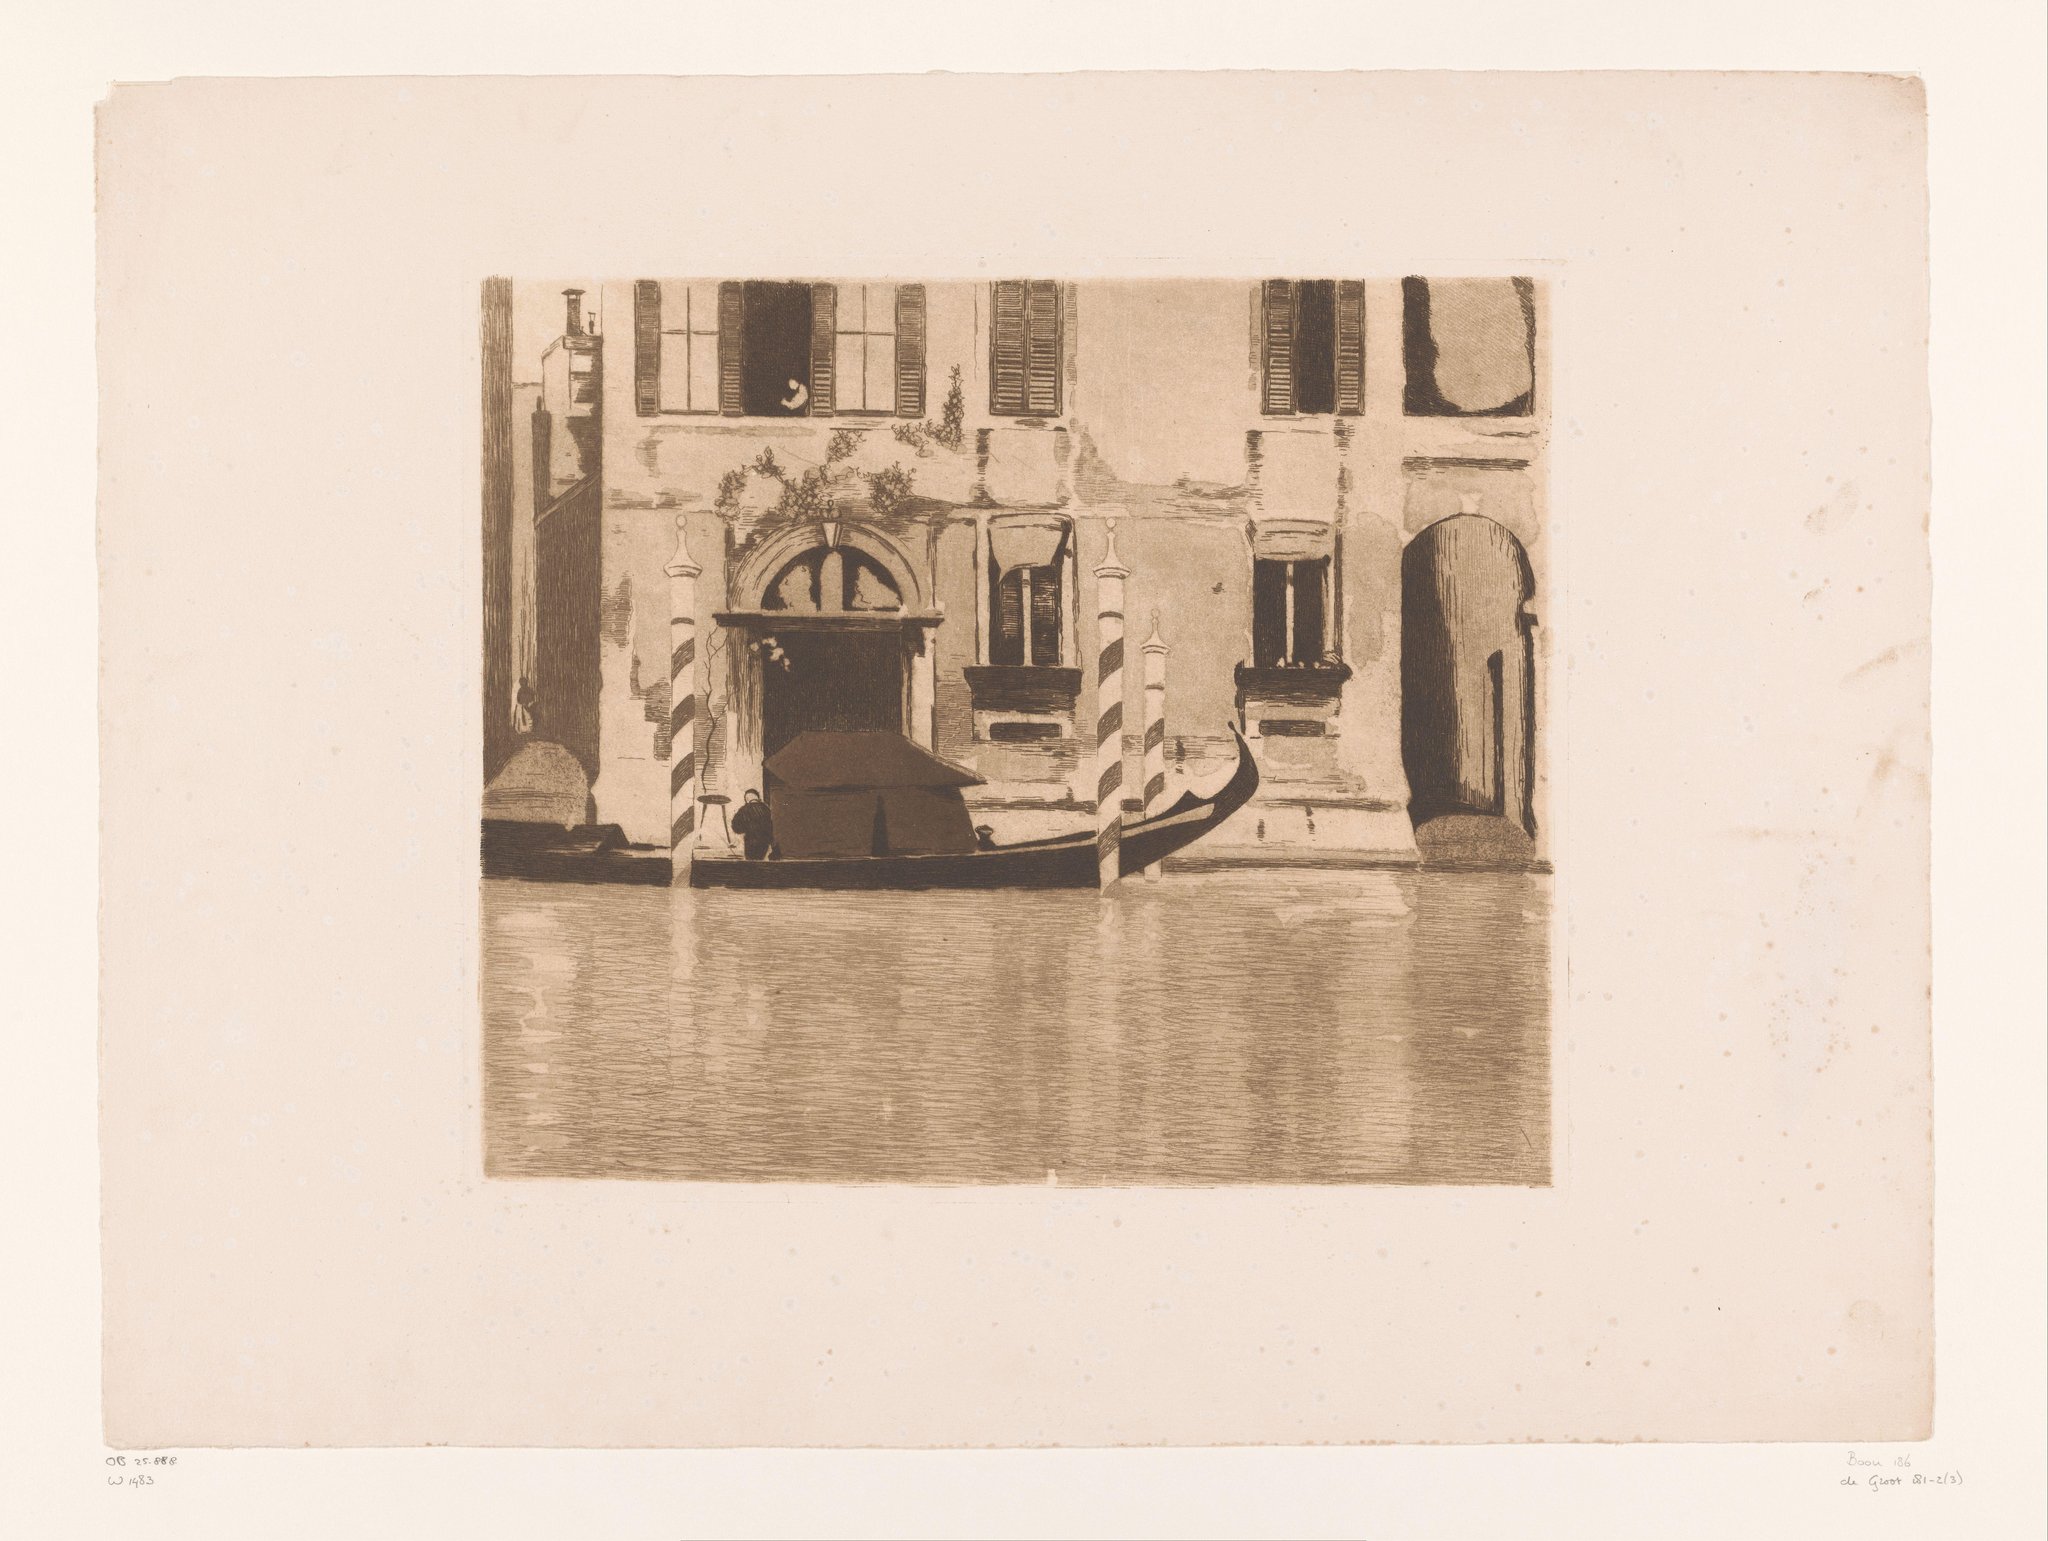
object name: print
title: Gondel met opbouw in het Canal Grande, Venetië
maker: willem witsen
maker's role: draughtsman, painter, print maker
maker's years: 1860-1923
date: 1914-1919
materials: paper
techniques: aquatint, etching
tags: canals, waters (in city), gondola, venice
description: De prent toont een huis aan het Canal Grande, dat is ingeklemd tussen Ramo Moro Lin en Ramo Grassi.